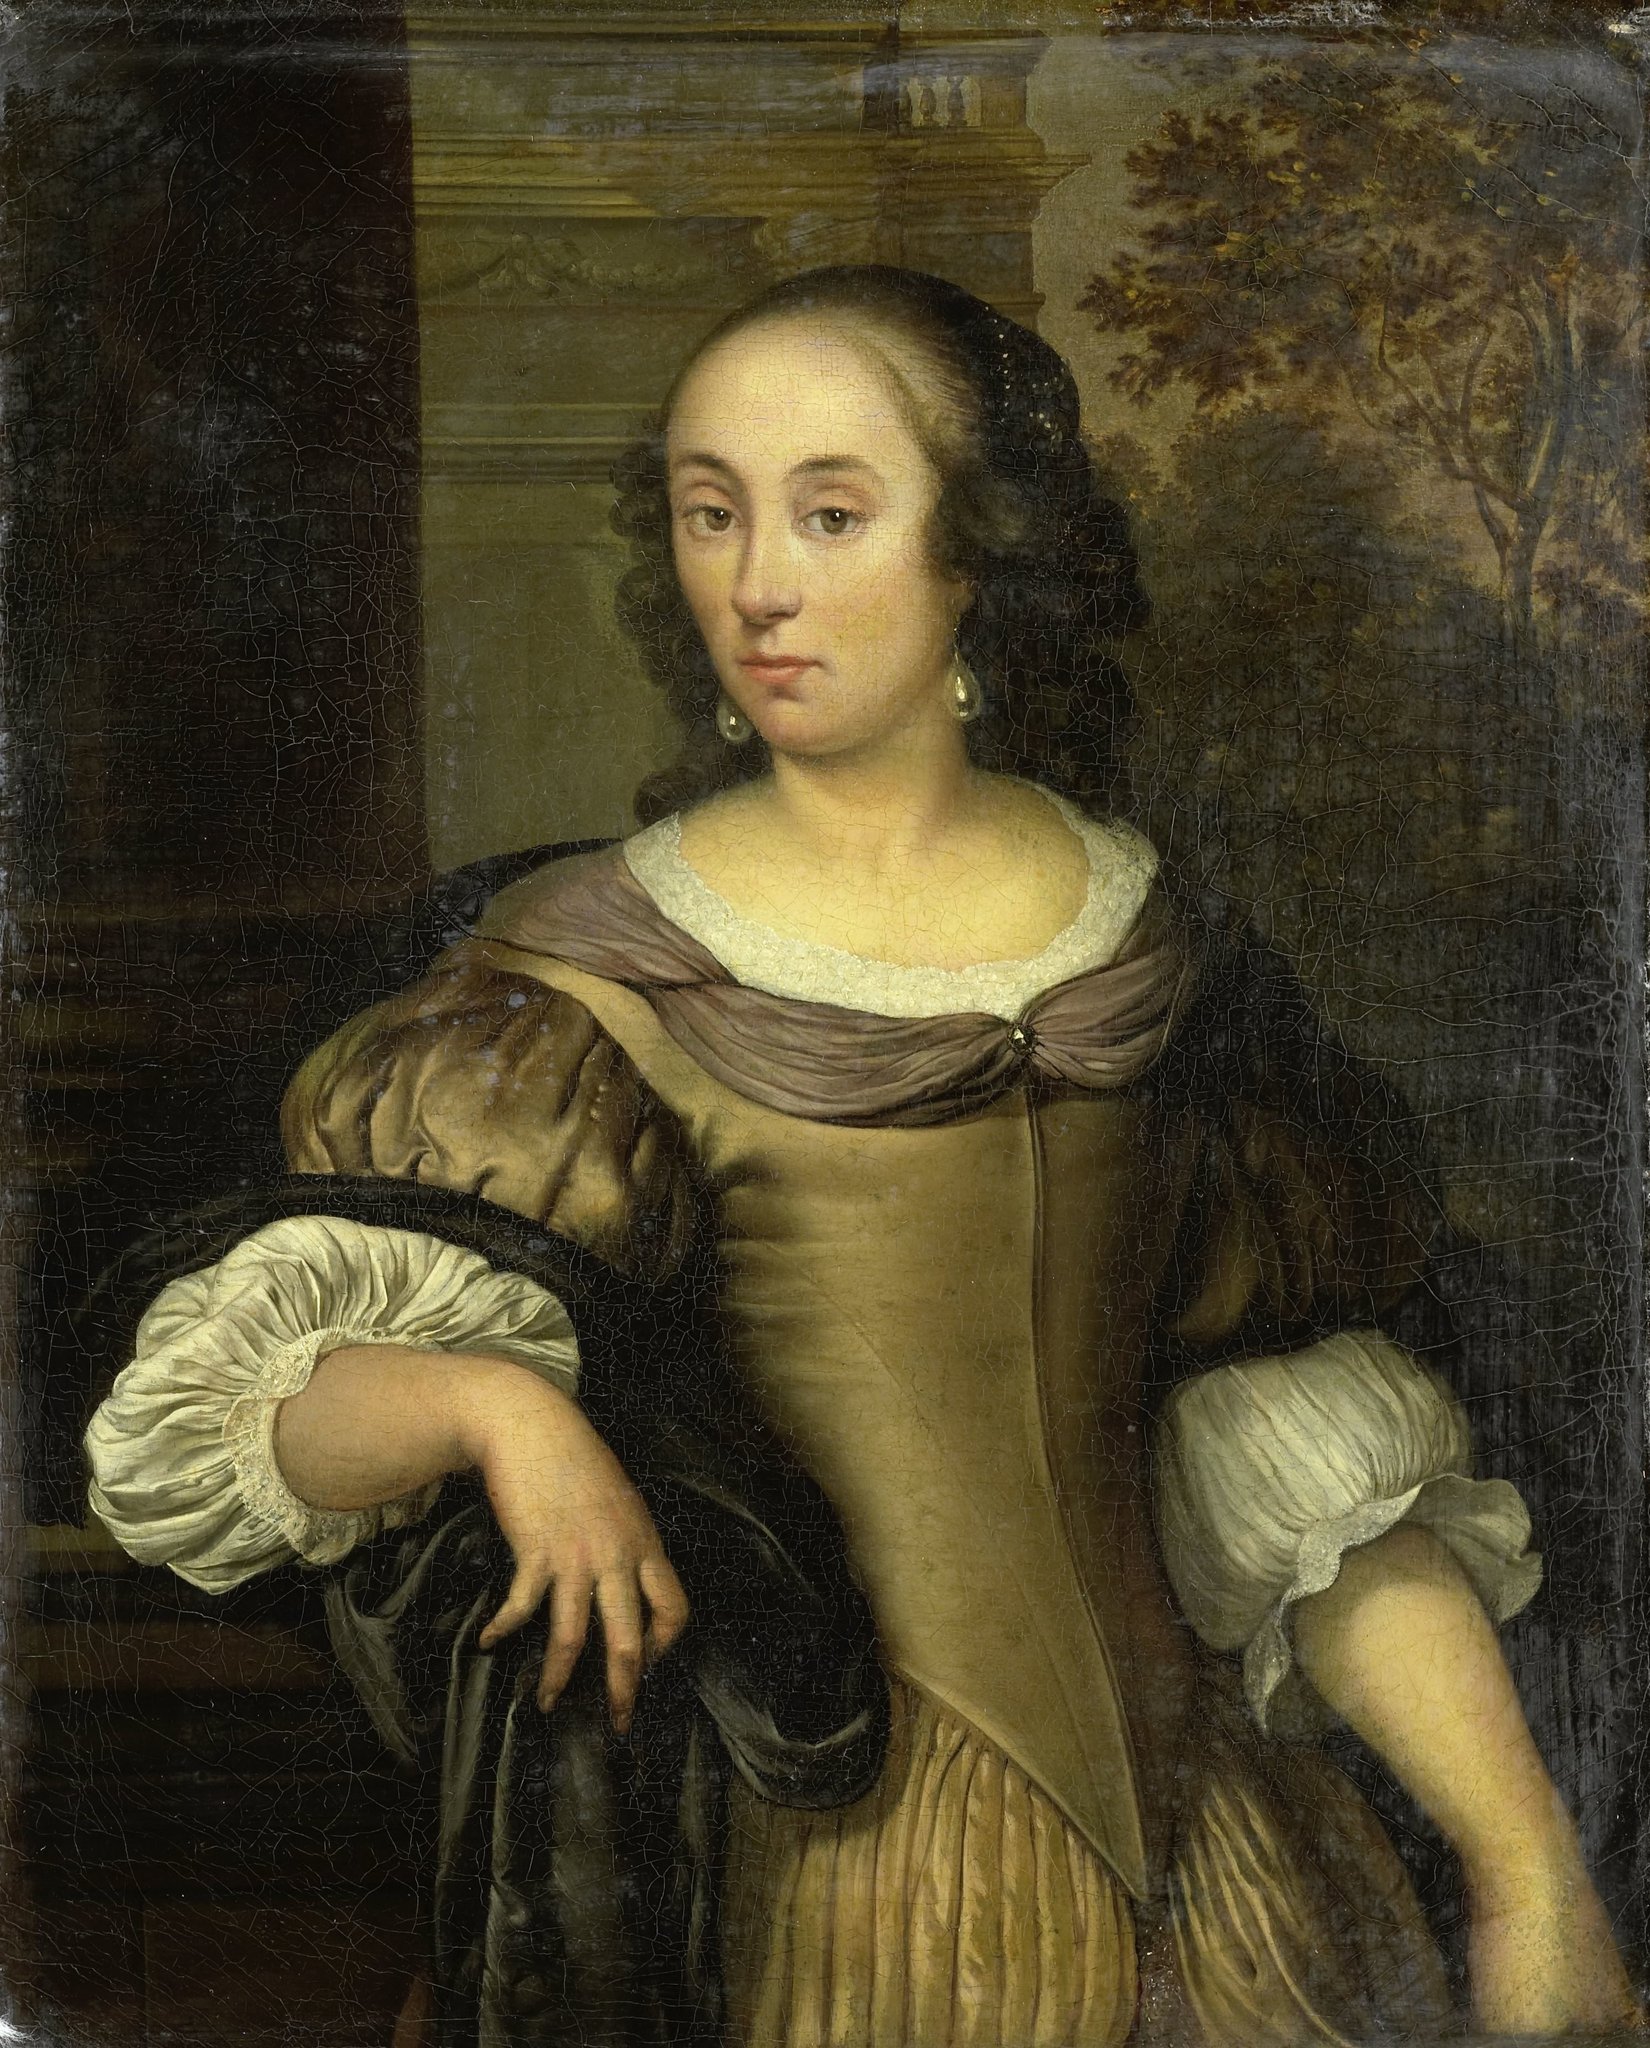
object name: painting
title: Portrait of a young woman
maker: eglon van der neer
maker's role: painter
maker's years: 1634-1703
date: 1650-1670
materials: canvas, oil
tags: adolescent, young woman, maiden, historical persons not known by name - bb - woman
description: Portret van een jonge vrouw. Ten halven lijve, staan met de rechterarm rustend op een piedestal. Op de achtergrond een huis en tuin.